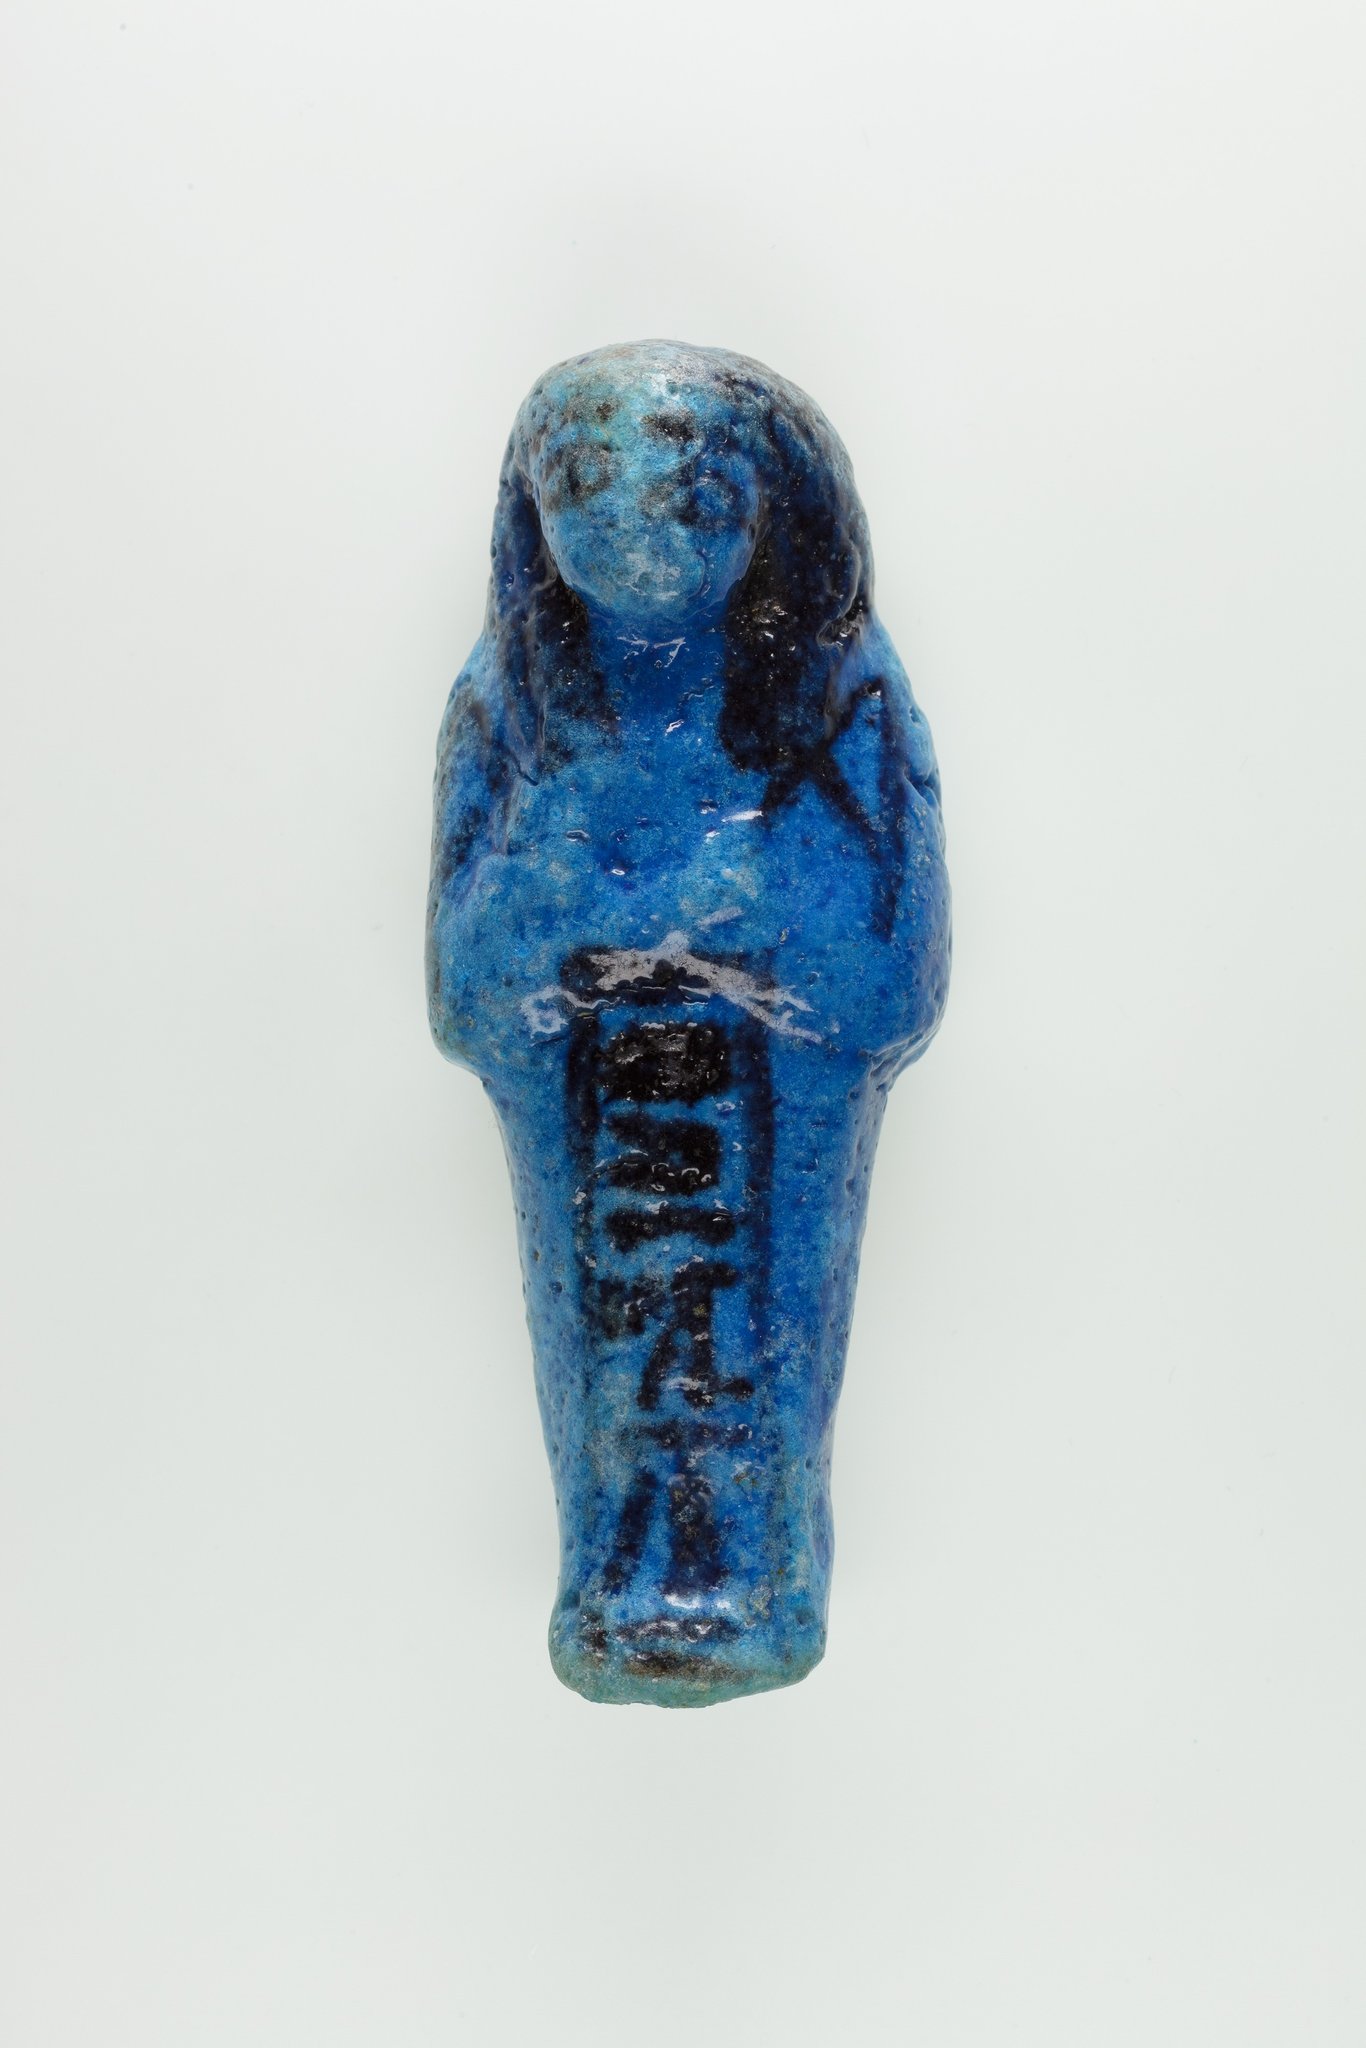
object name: shabti, worker, nauny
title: Worker Shabti of Nauny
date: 1050 BCE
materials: faience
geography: egypt